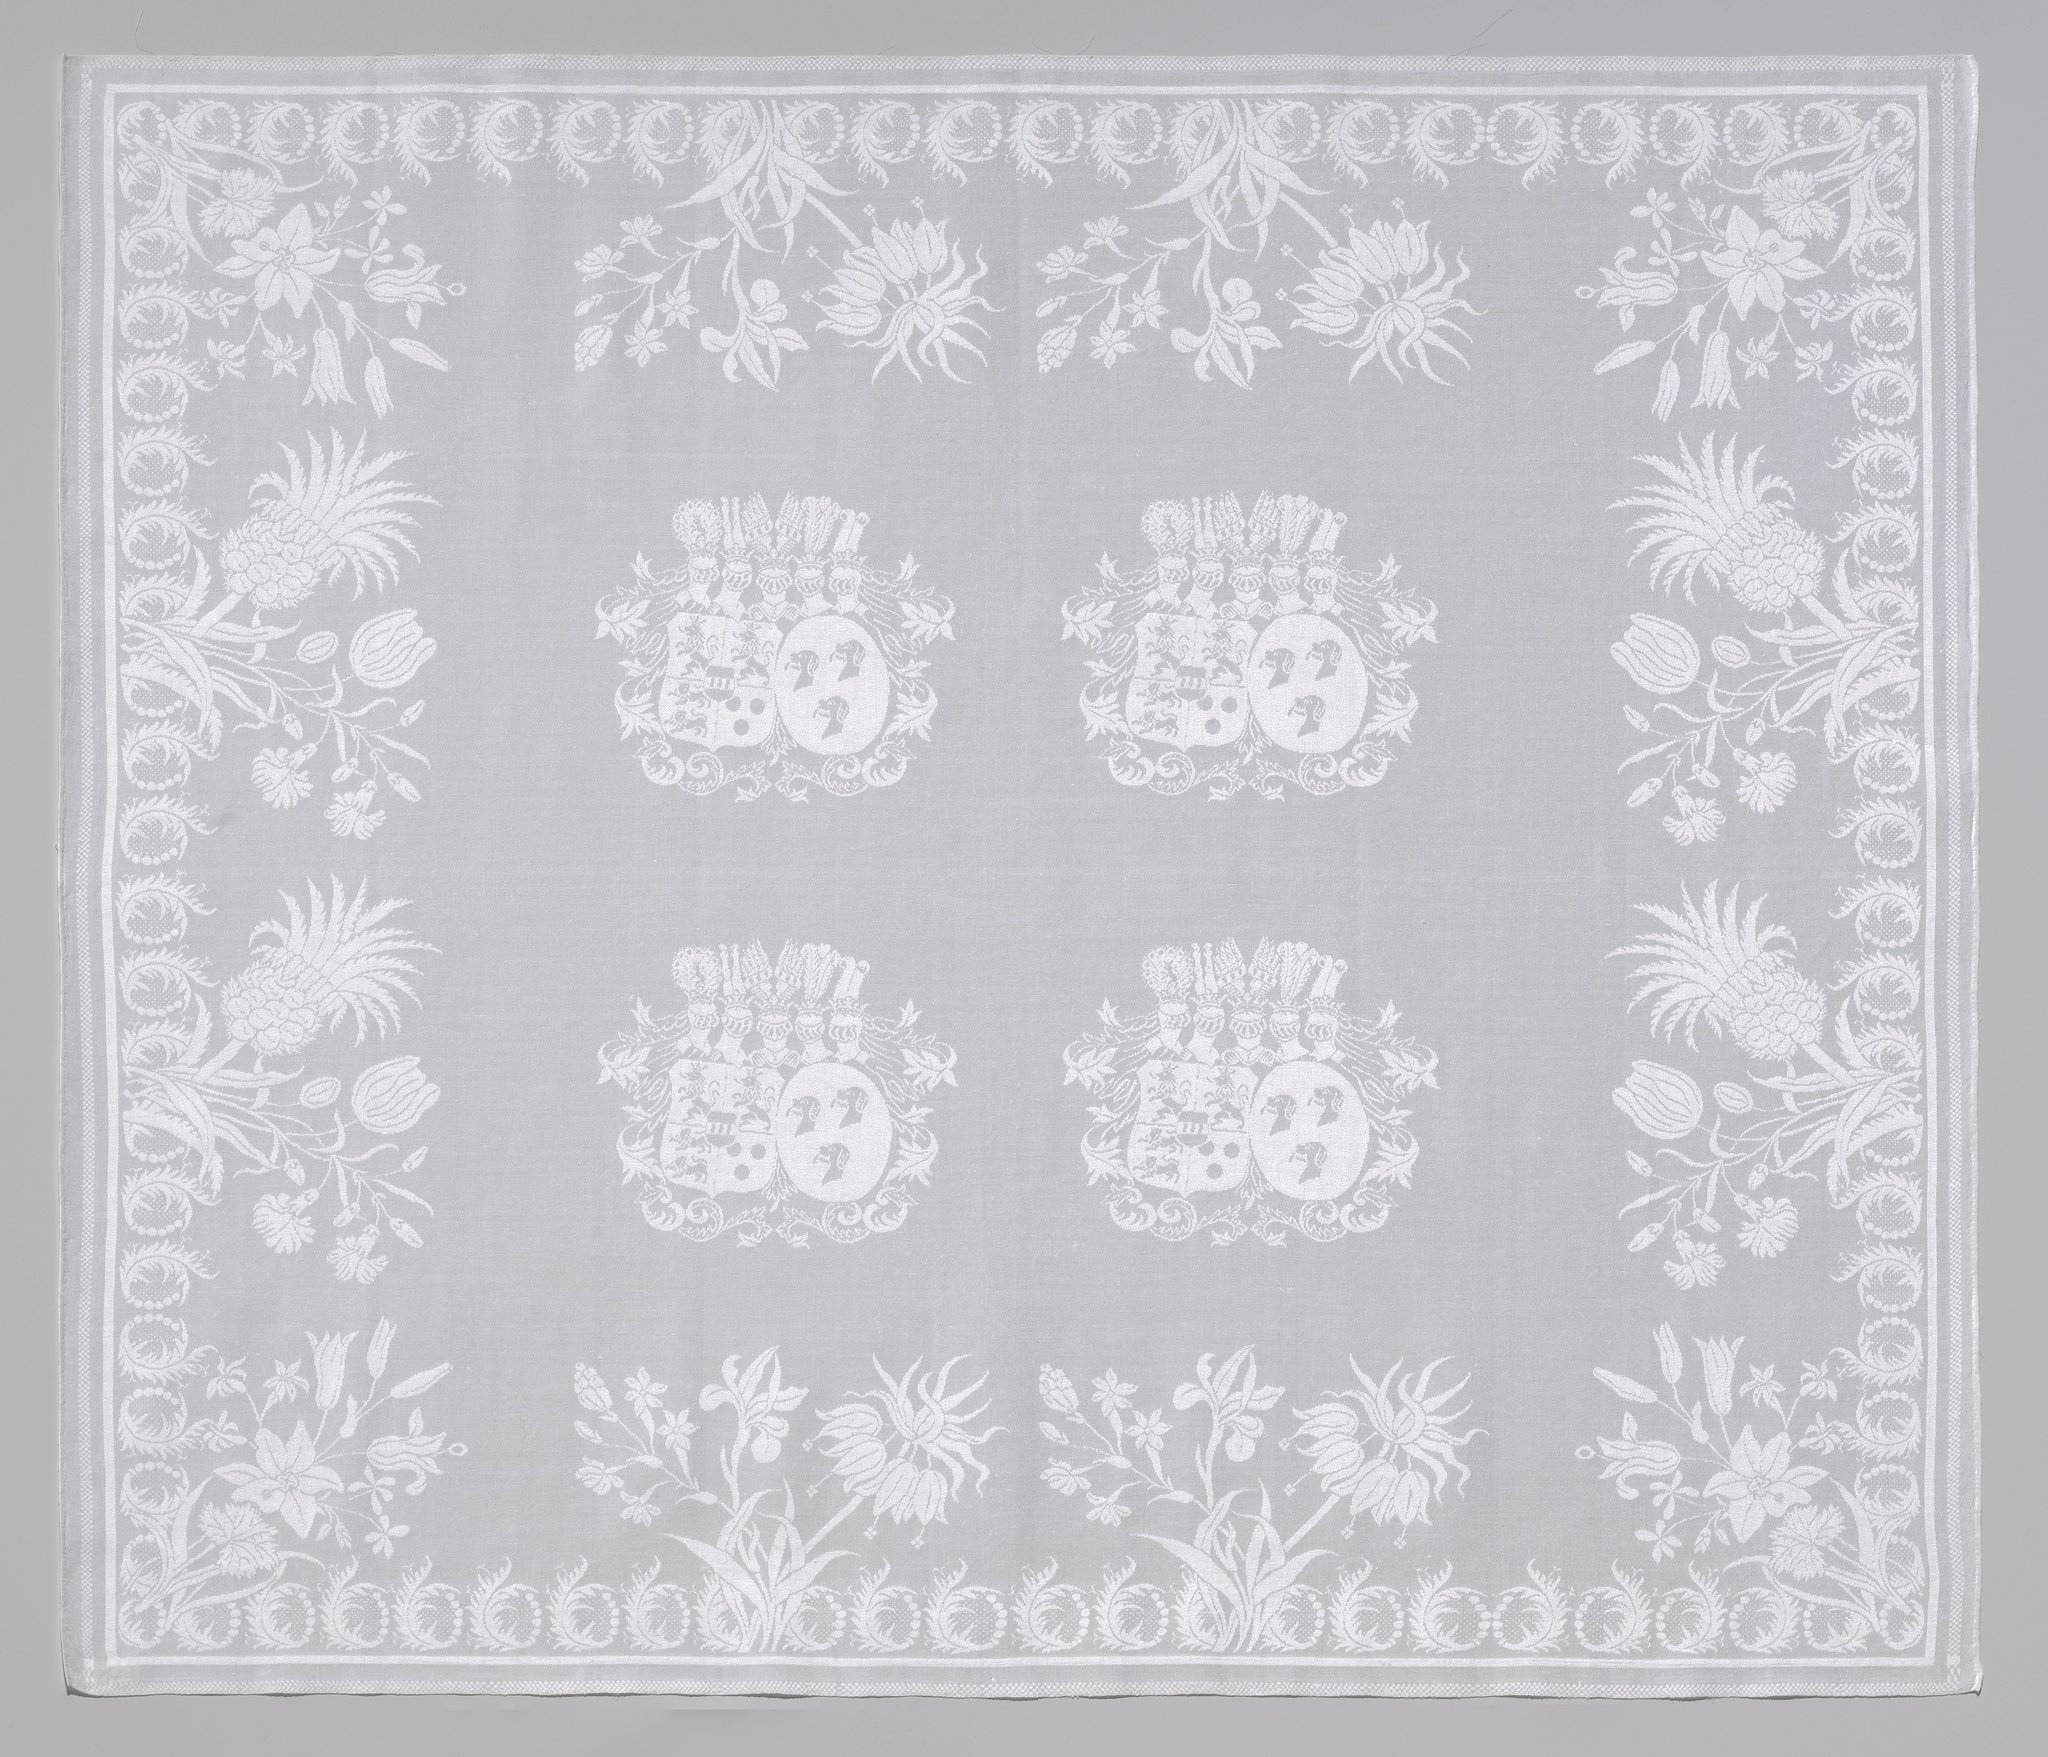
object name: napkin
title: Servet van linnendamast met wapens van Limburg Stirum en van Tuyll van Serooskerken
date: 1890-1910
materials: linen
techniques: damask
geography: veghel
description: Wit linnendamasten servet met wapens van Limburg Stirum en van Tuyll van Serooskerken, merk: WH.